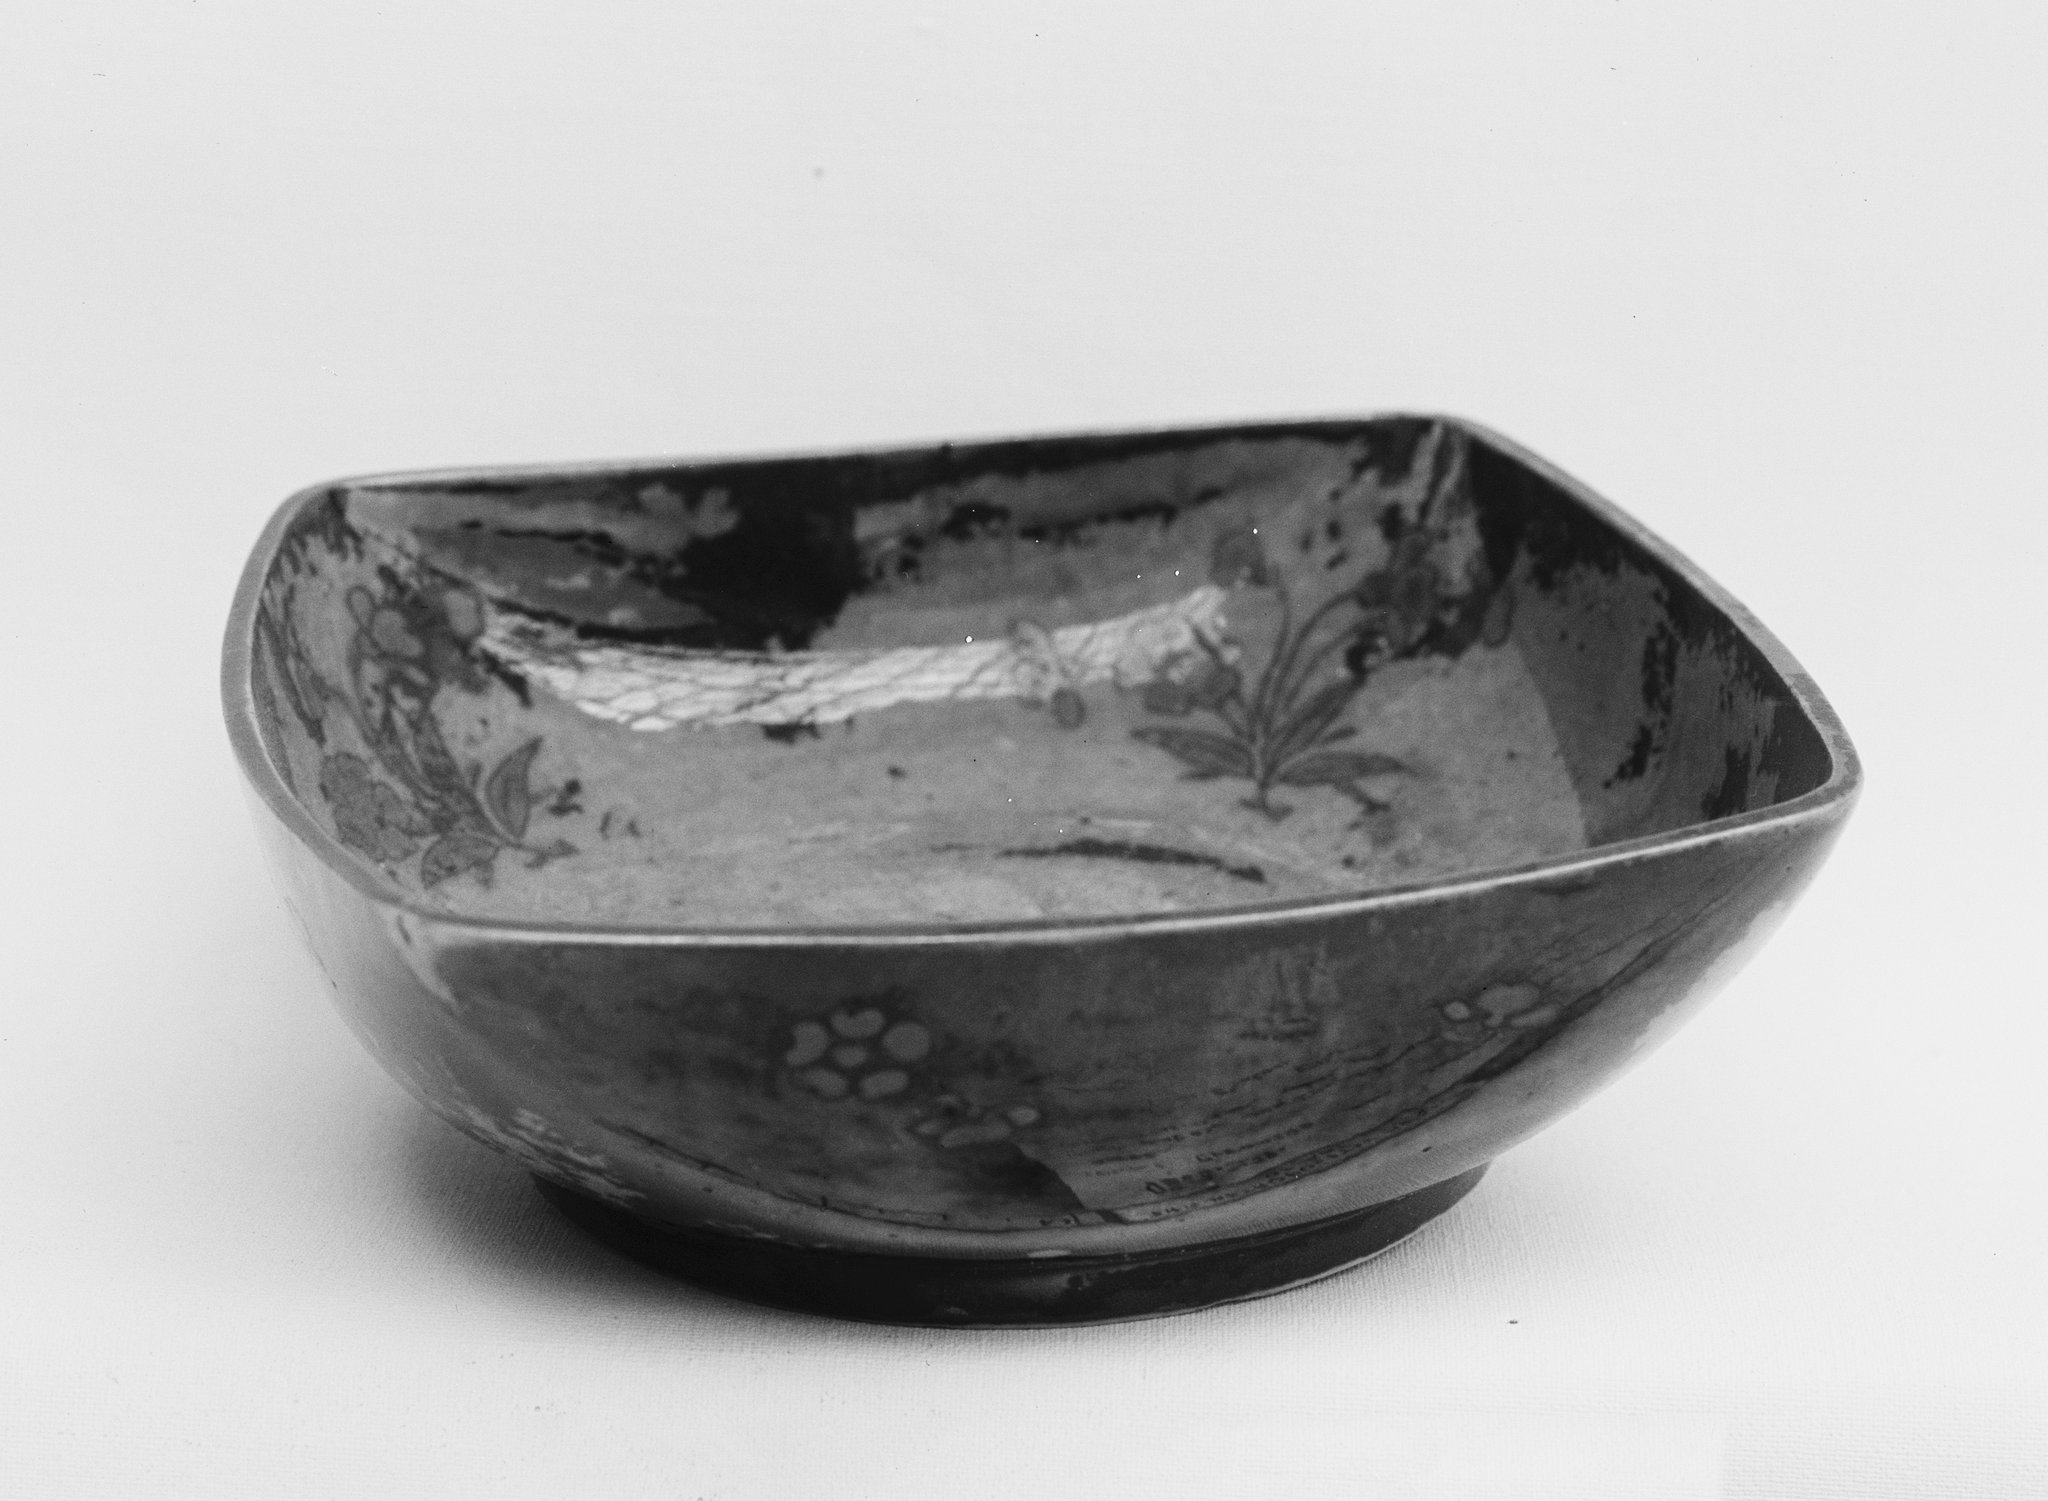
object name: bowl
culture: japanese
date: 1720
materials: enamel, glaze, porcelain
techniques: polychrome